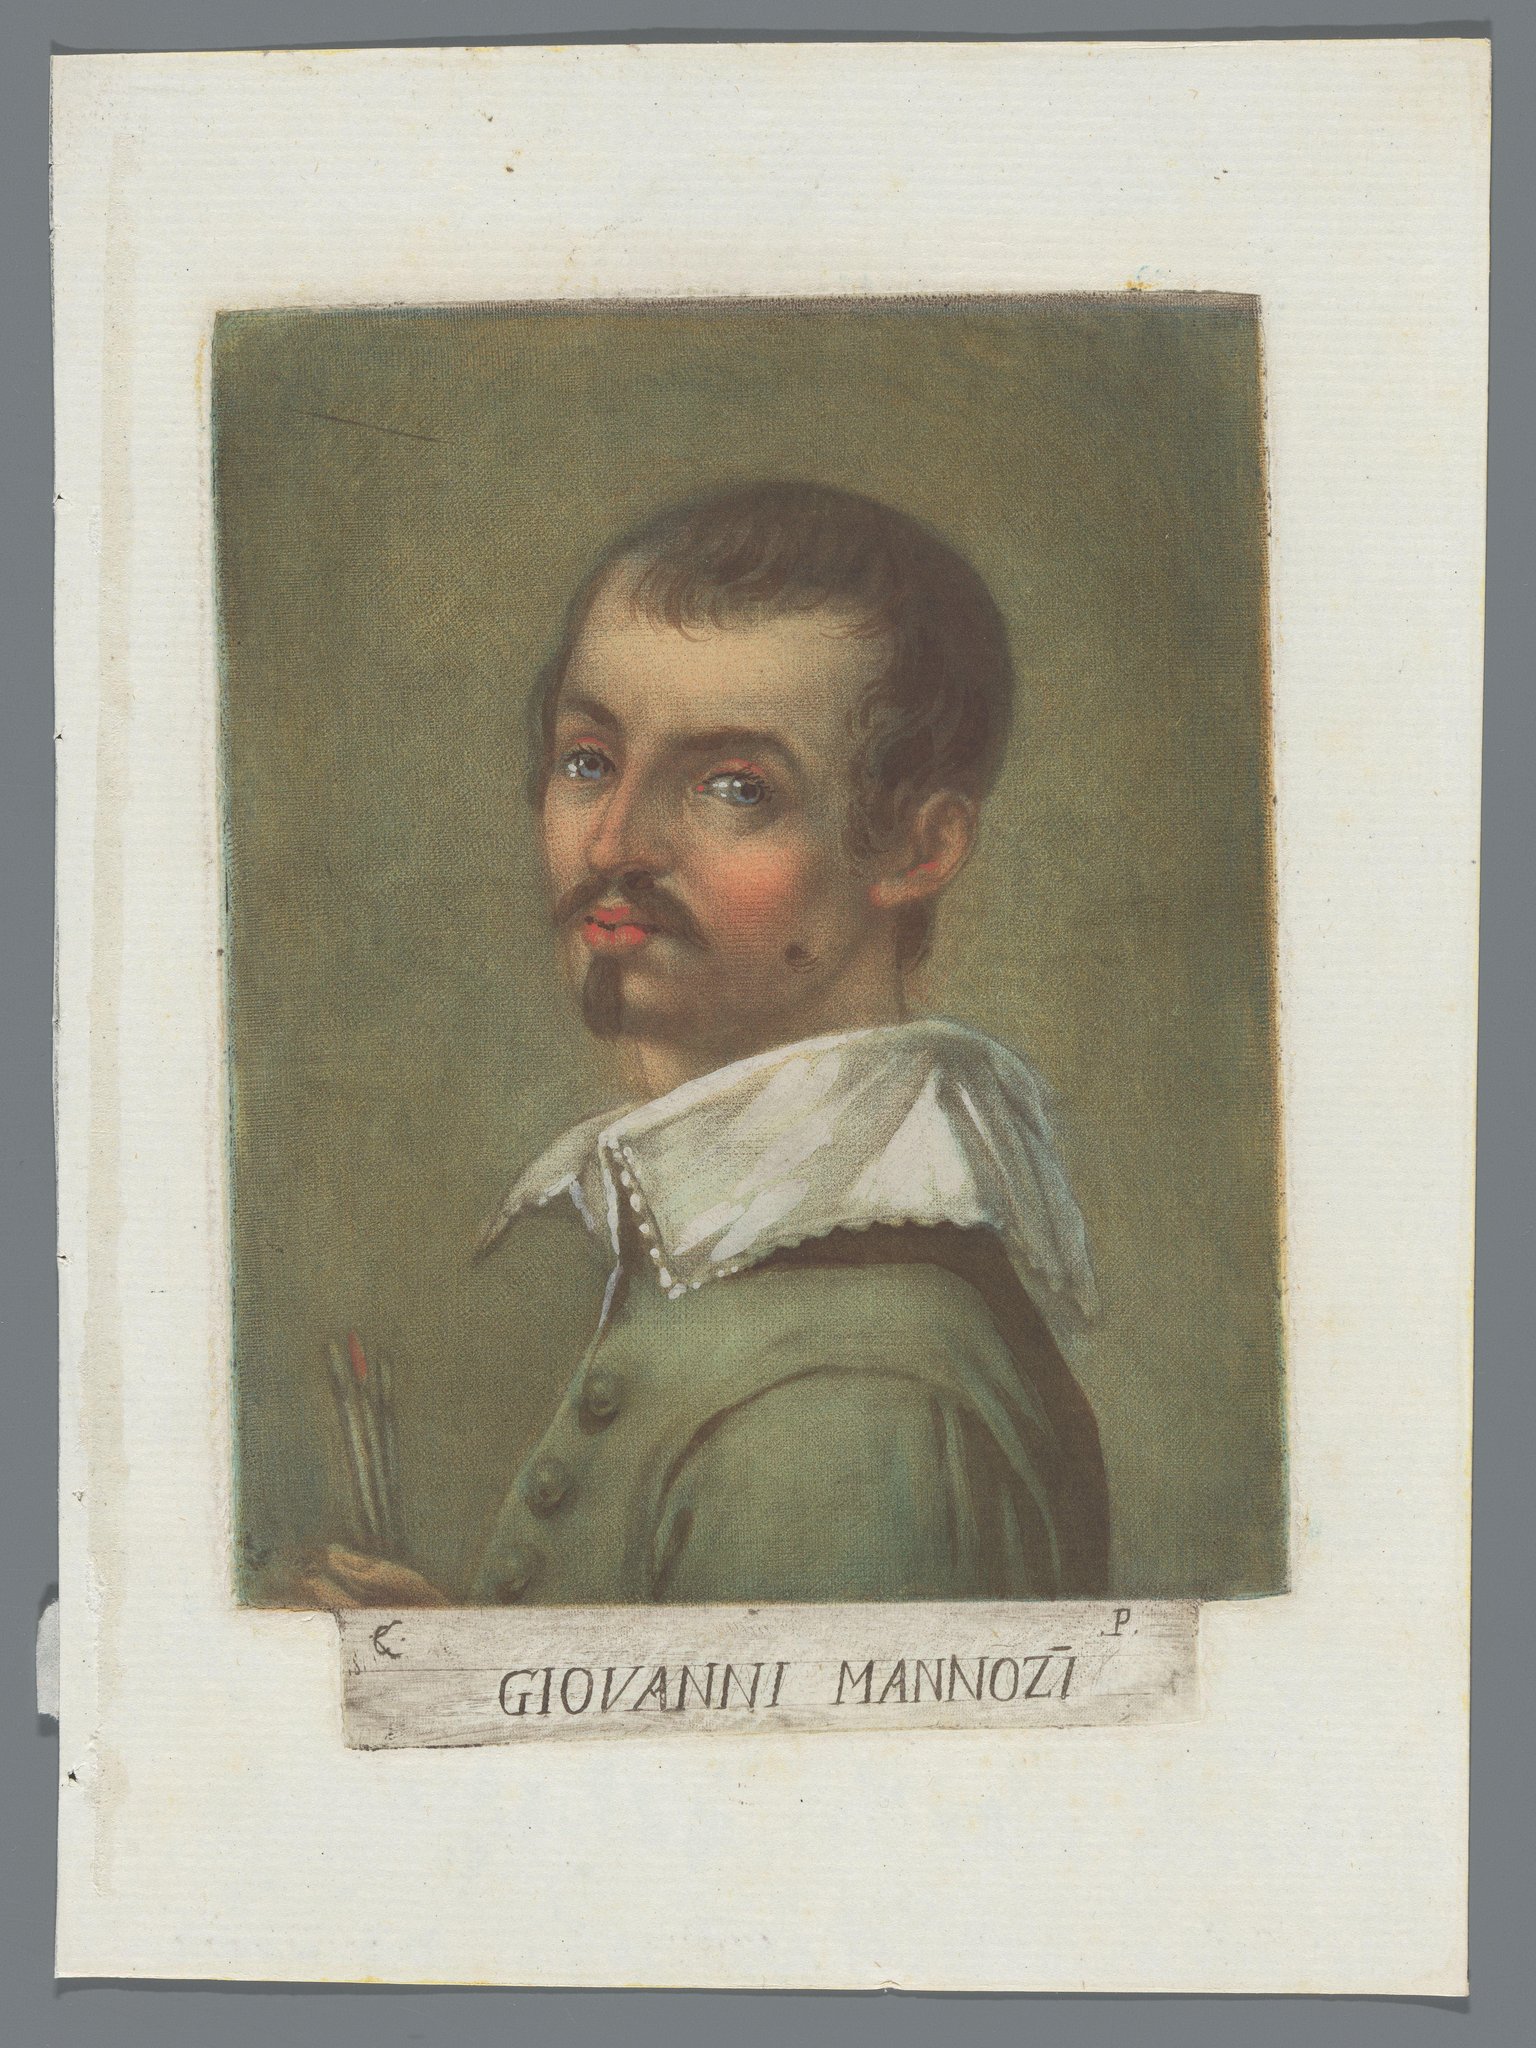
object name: print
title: Giovanni Mannoz[z]i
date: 1789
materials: gouache, paper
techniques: color mezzotint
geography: florence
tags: draughtsman, giovanni mannozzi, historical persons, portrait, self-portrait of painter, portrait, self-portrait of artist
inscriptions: inscription:, number: ‘30’, collector's mark: Lugt 2228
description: Een prent uit een groep van veertig kleurendrukken met kunstenaarsportretten, gebaseerd op de collectie geschilderde zelfportretten van kunstenaars verzameld door de Medici in Florence. De groep maakt deel uit van het grote werk van Lasinio ‘Gli Autoritratti della Real Galleria di Firenze’, uitgegeven in 1789 met omstreeks 350 kunstenaarsportretten. Van deze uitgave is tot nog toe is geen compleet exemplaar bekend. In de inspringende marges onderaan de prenten zijn de namen van de kunstenaars aangebracht en soms hun levensdata en de plaats van geboorte en sterven en een enkele maal de signatuur van Lasinio en dat van de drukker Labrelis. Getuige de bindgaatjes en lijmresten moeten de prenten ingebonden zijn geweest in een album. De meeste prenten zijn verso voorzien van nummers in potlood, met als laagste nummer 2 en hoogste 93. Tevens zijn er verso Italiaanse opschriften in pen aangebracht met de levensdata van de kunstenaars en de school waartoe zij worden gerekend. Deze opschriften zijn vrijwel alle deels afgesneden. Elf prenten zijn niet genummerd en niet voorzien van opschriften. Deze laatste elf zijn alle gedrukt op blauw papier.